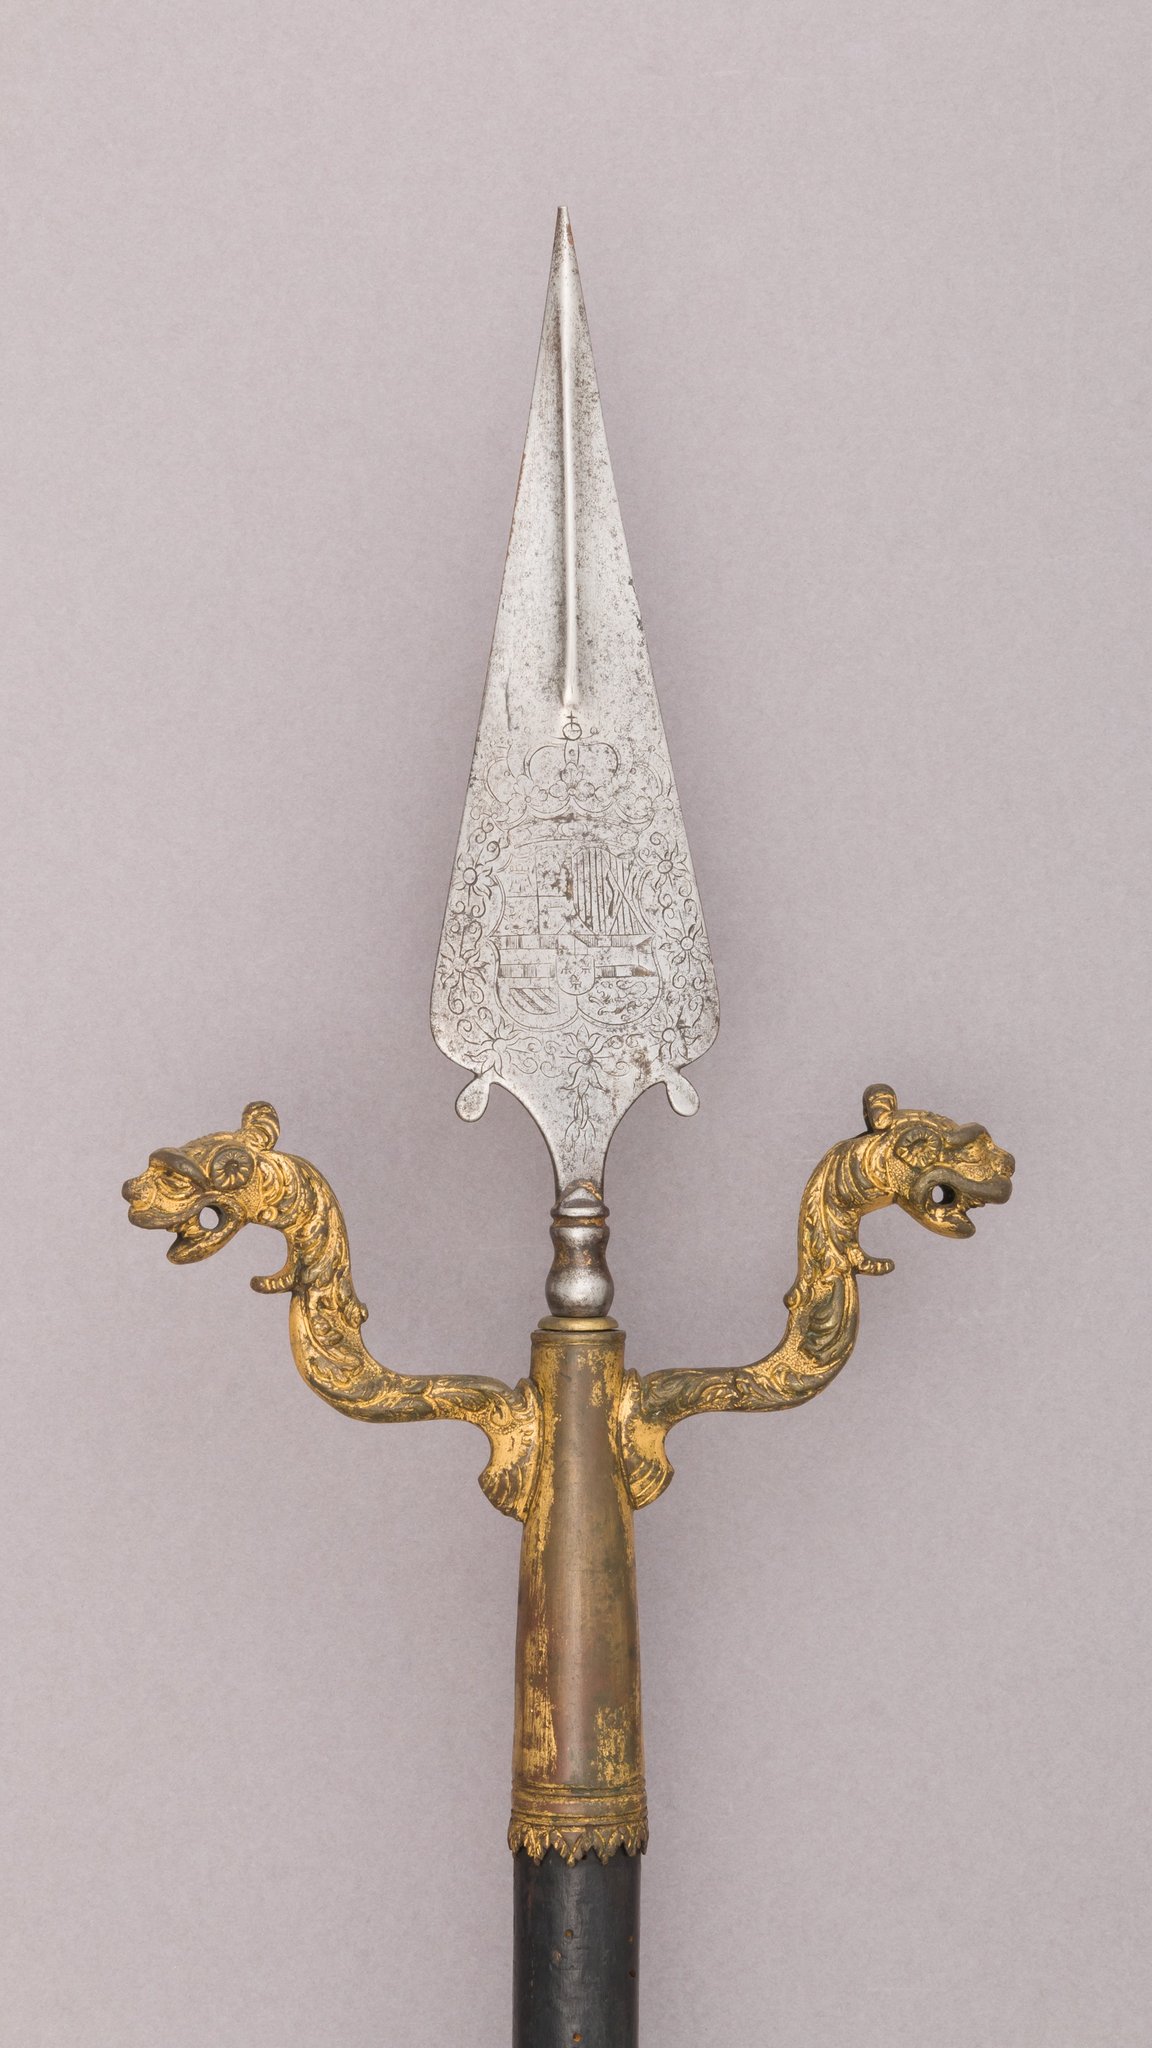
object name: linstock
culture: european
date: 1701-1733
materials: steel, wood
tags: coat of arms